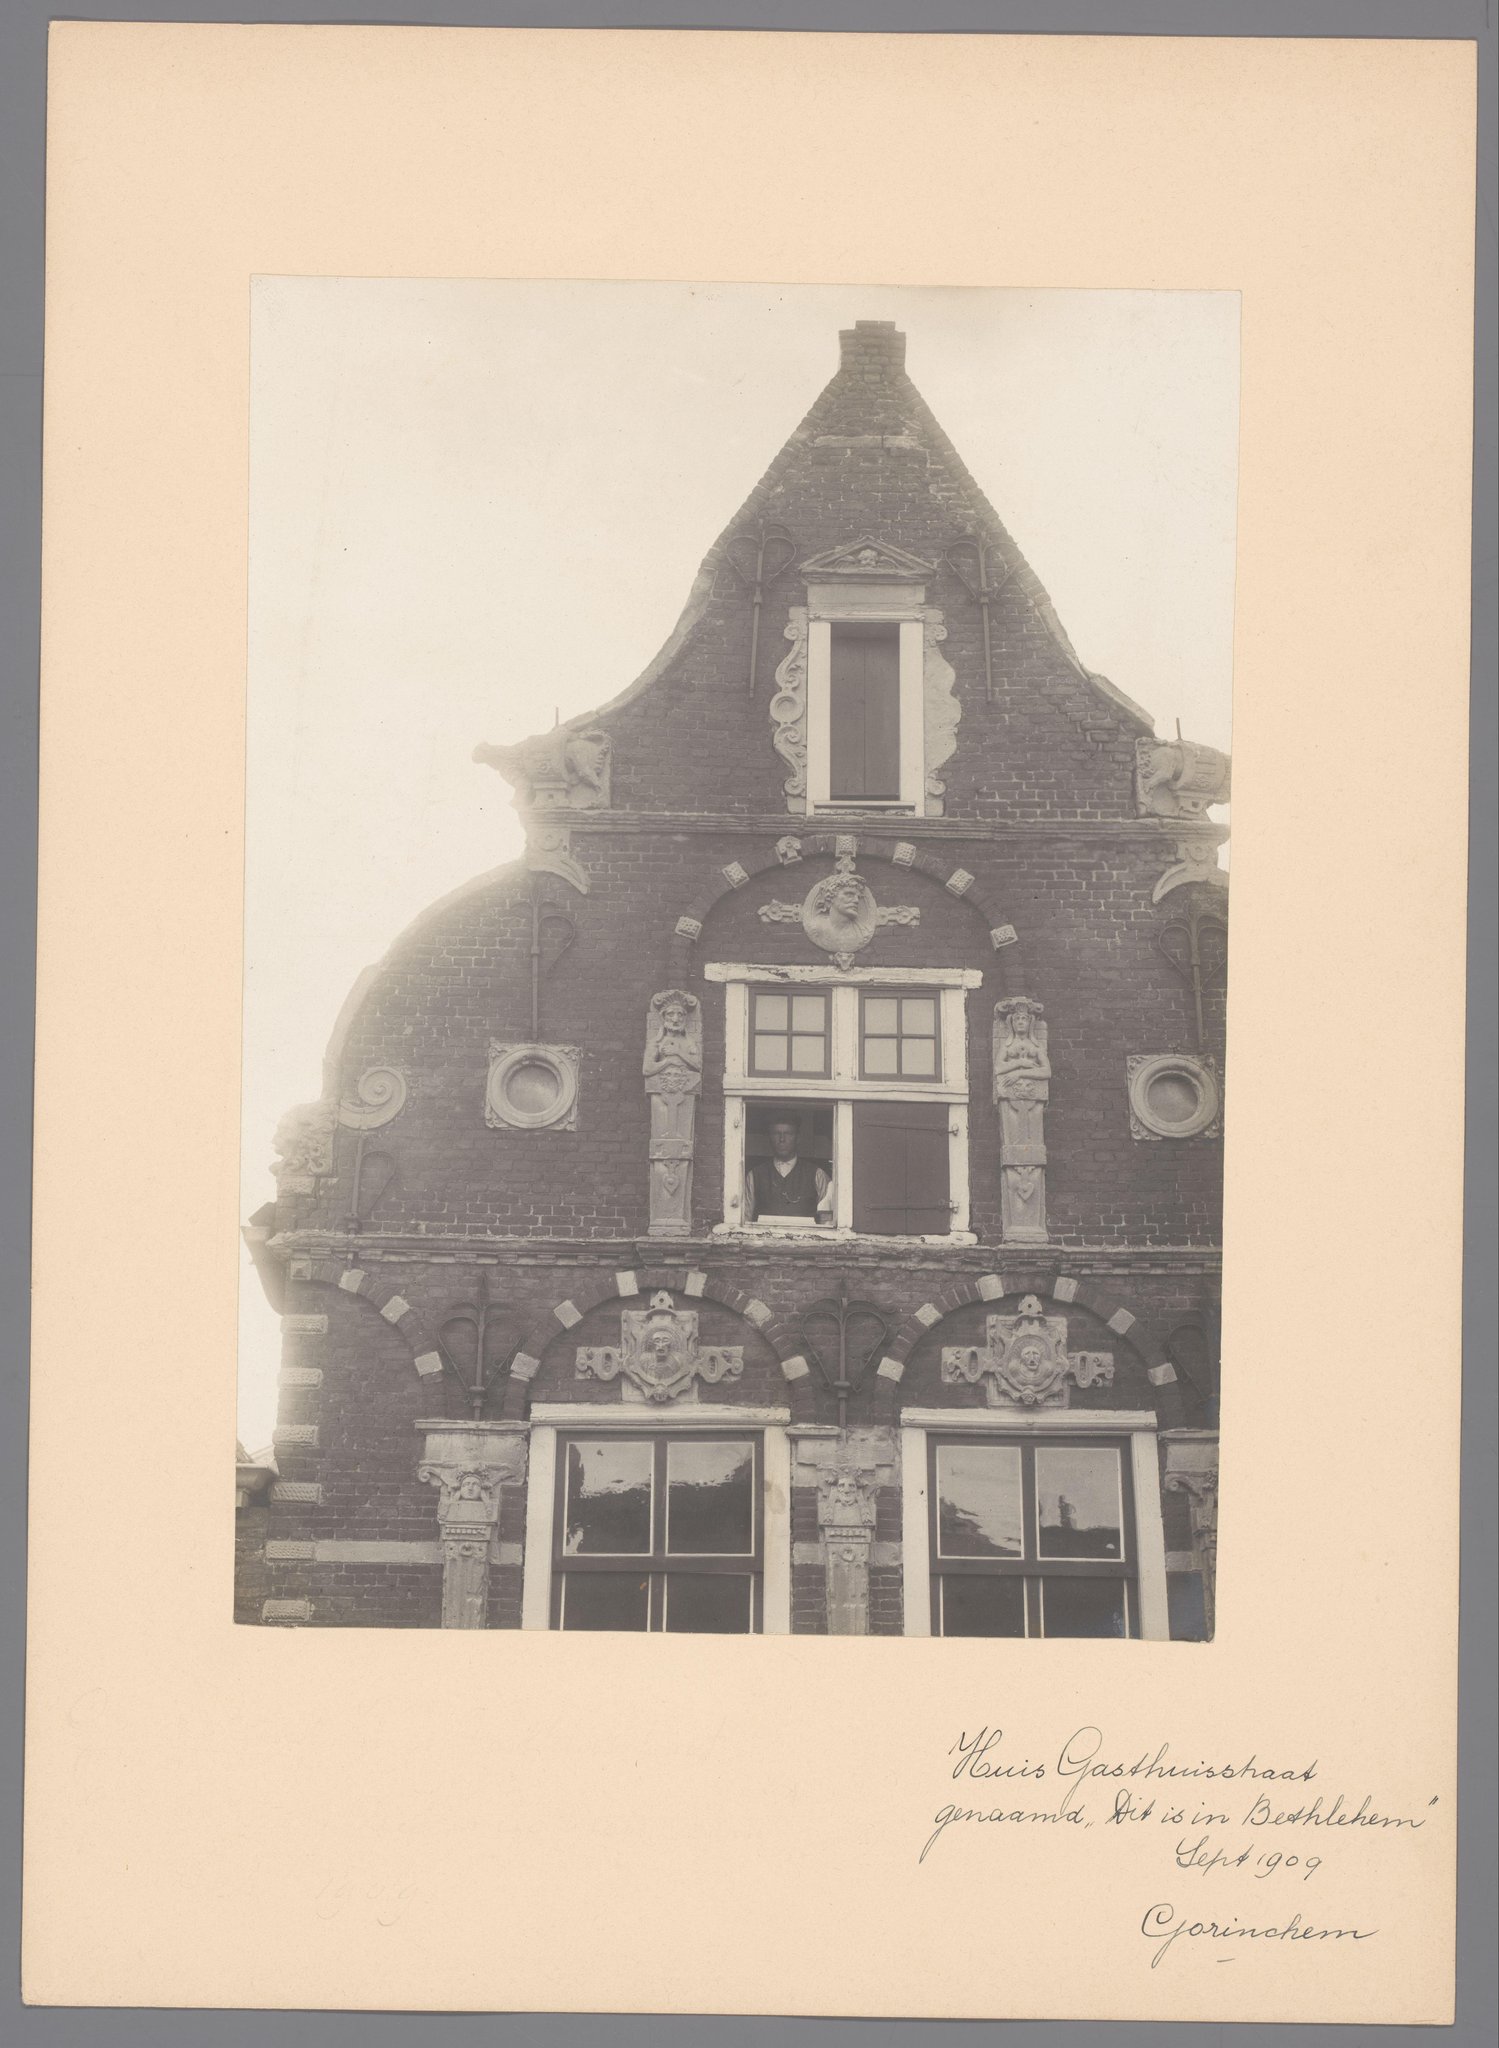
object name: photograph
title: Detail van het pand Dit is in Bethlehem te Gorinchem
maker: anoniem (monumentenzorg)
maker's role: fotograaf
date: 1909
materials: cardboard, photographic support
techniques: gelatin silver print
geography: gasthuisstraat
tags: urban housing, façade (of house or building)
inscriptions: annotation: ‘M. de Wilde/ 1682-’, annotation: ‘Huis Gasthuisstraat genaamd "Dit is in Bethlehem"/ Sept. 1909/ Gorinchem’